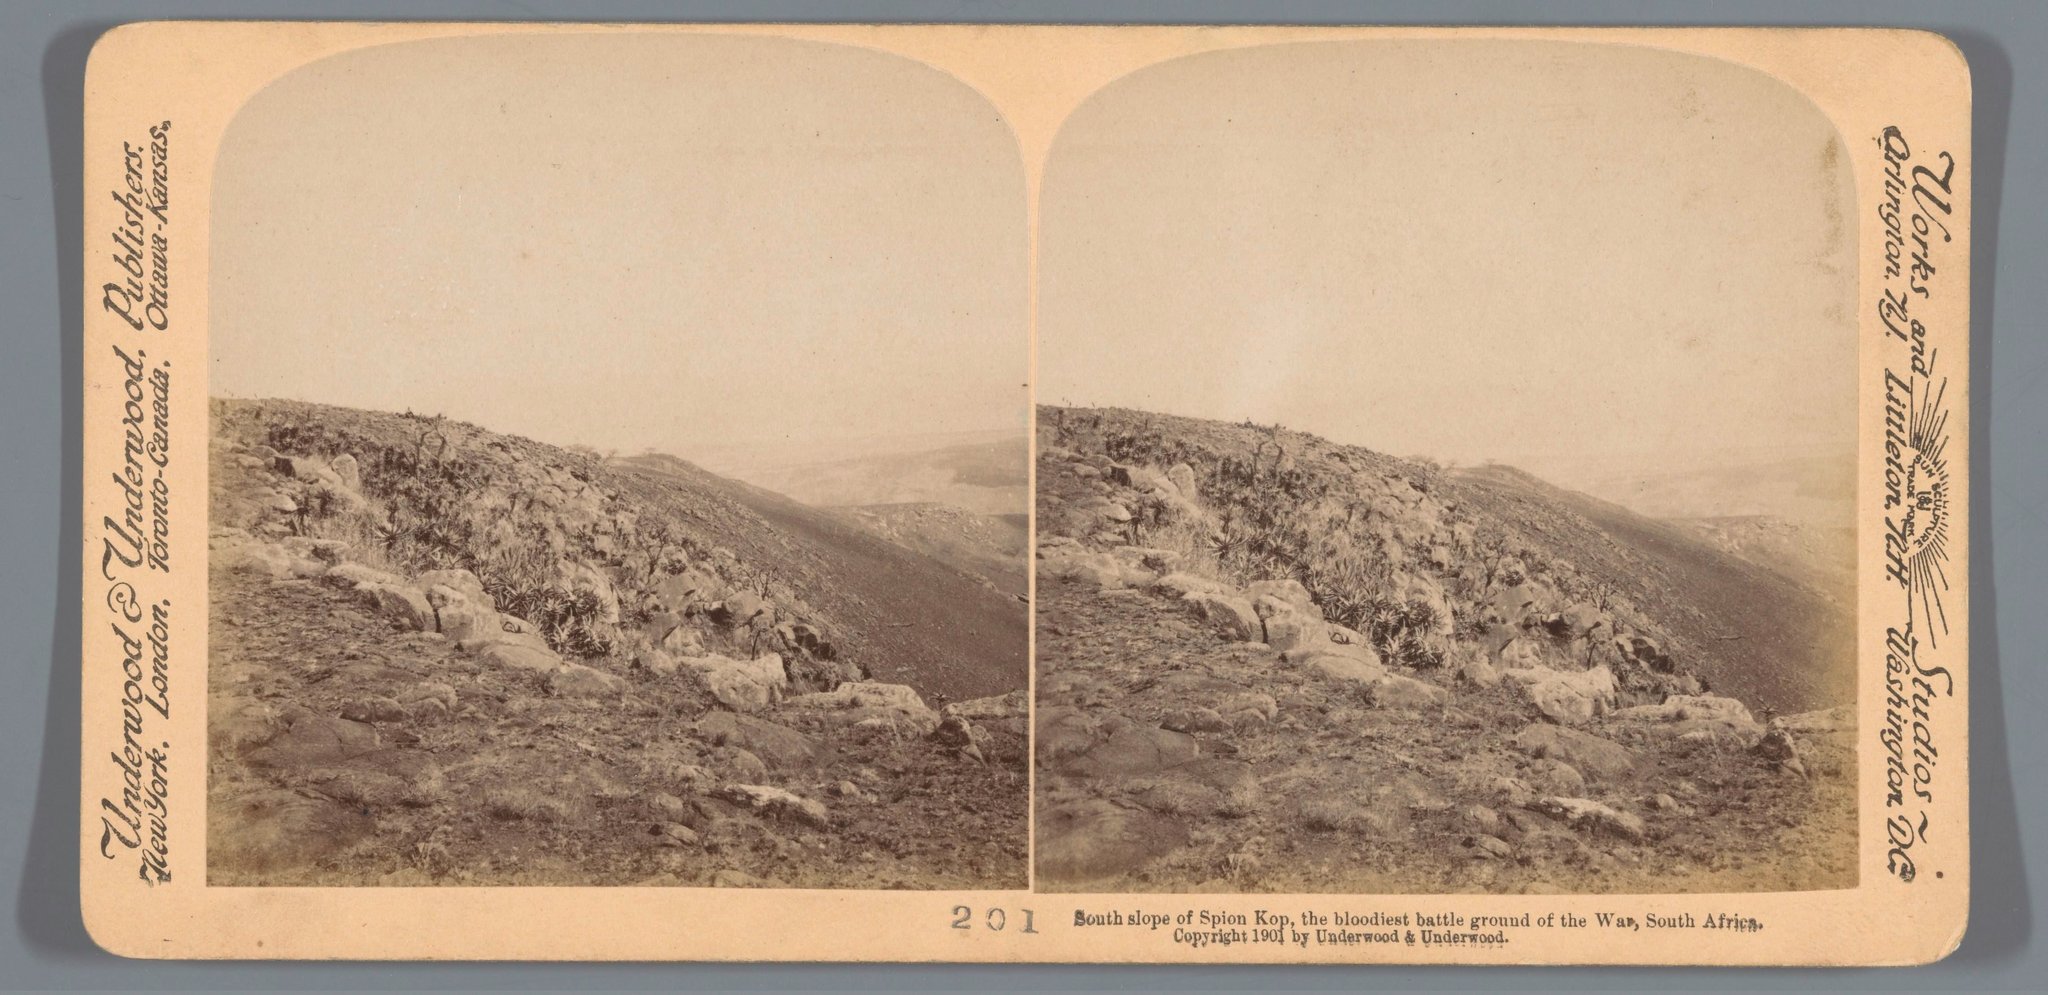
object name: stereograph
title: South Slope of Spion Kop, the bloodiest battle ground of the War, South Africa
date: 1901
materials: cardboard, photographic support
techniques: albumen print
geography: spionkop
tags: (high) hill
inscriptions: name: ‘Works and Studios Sun Sculpture trade mark Arlington N.J. Littleton N.H. Washington D.C.’, number: ‘201’